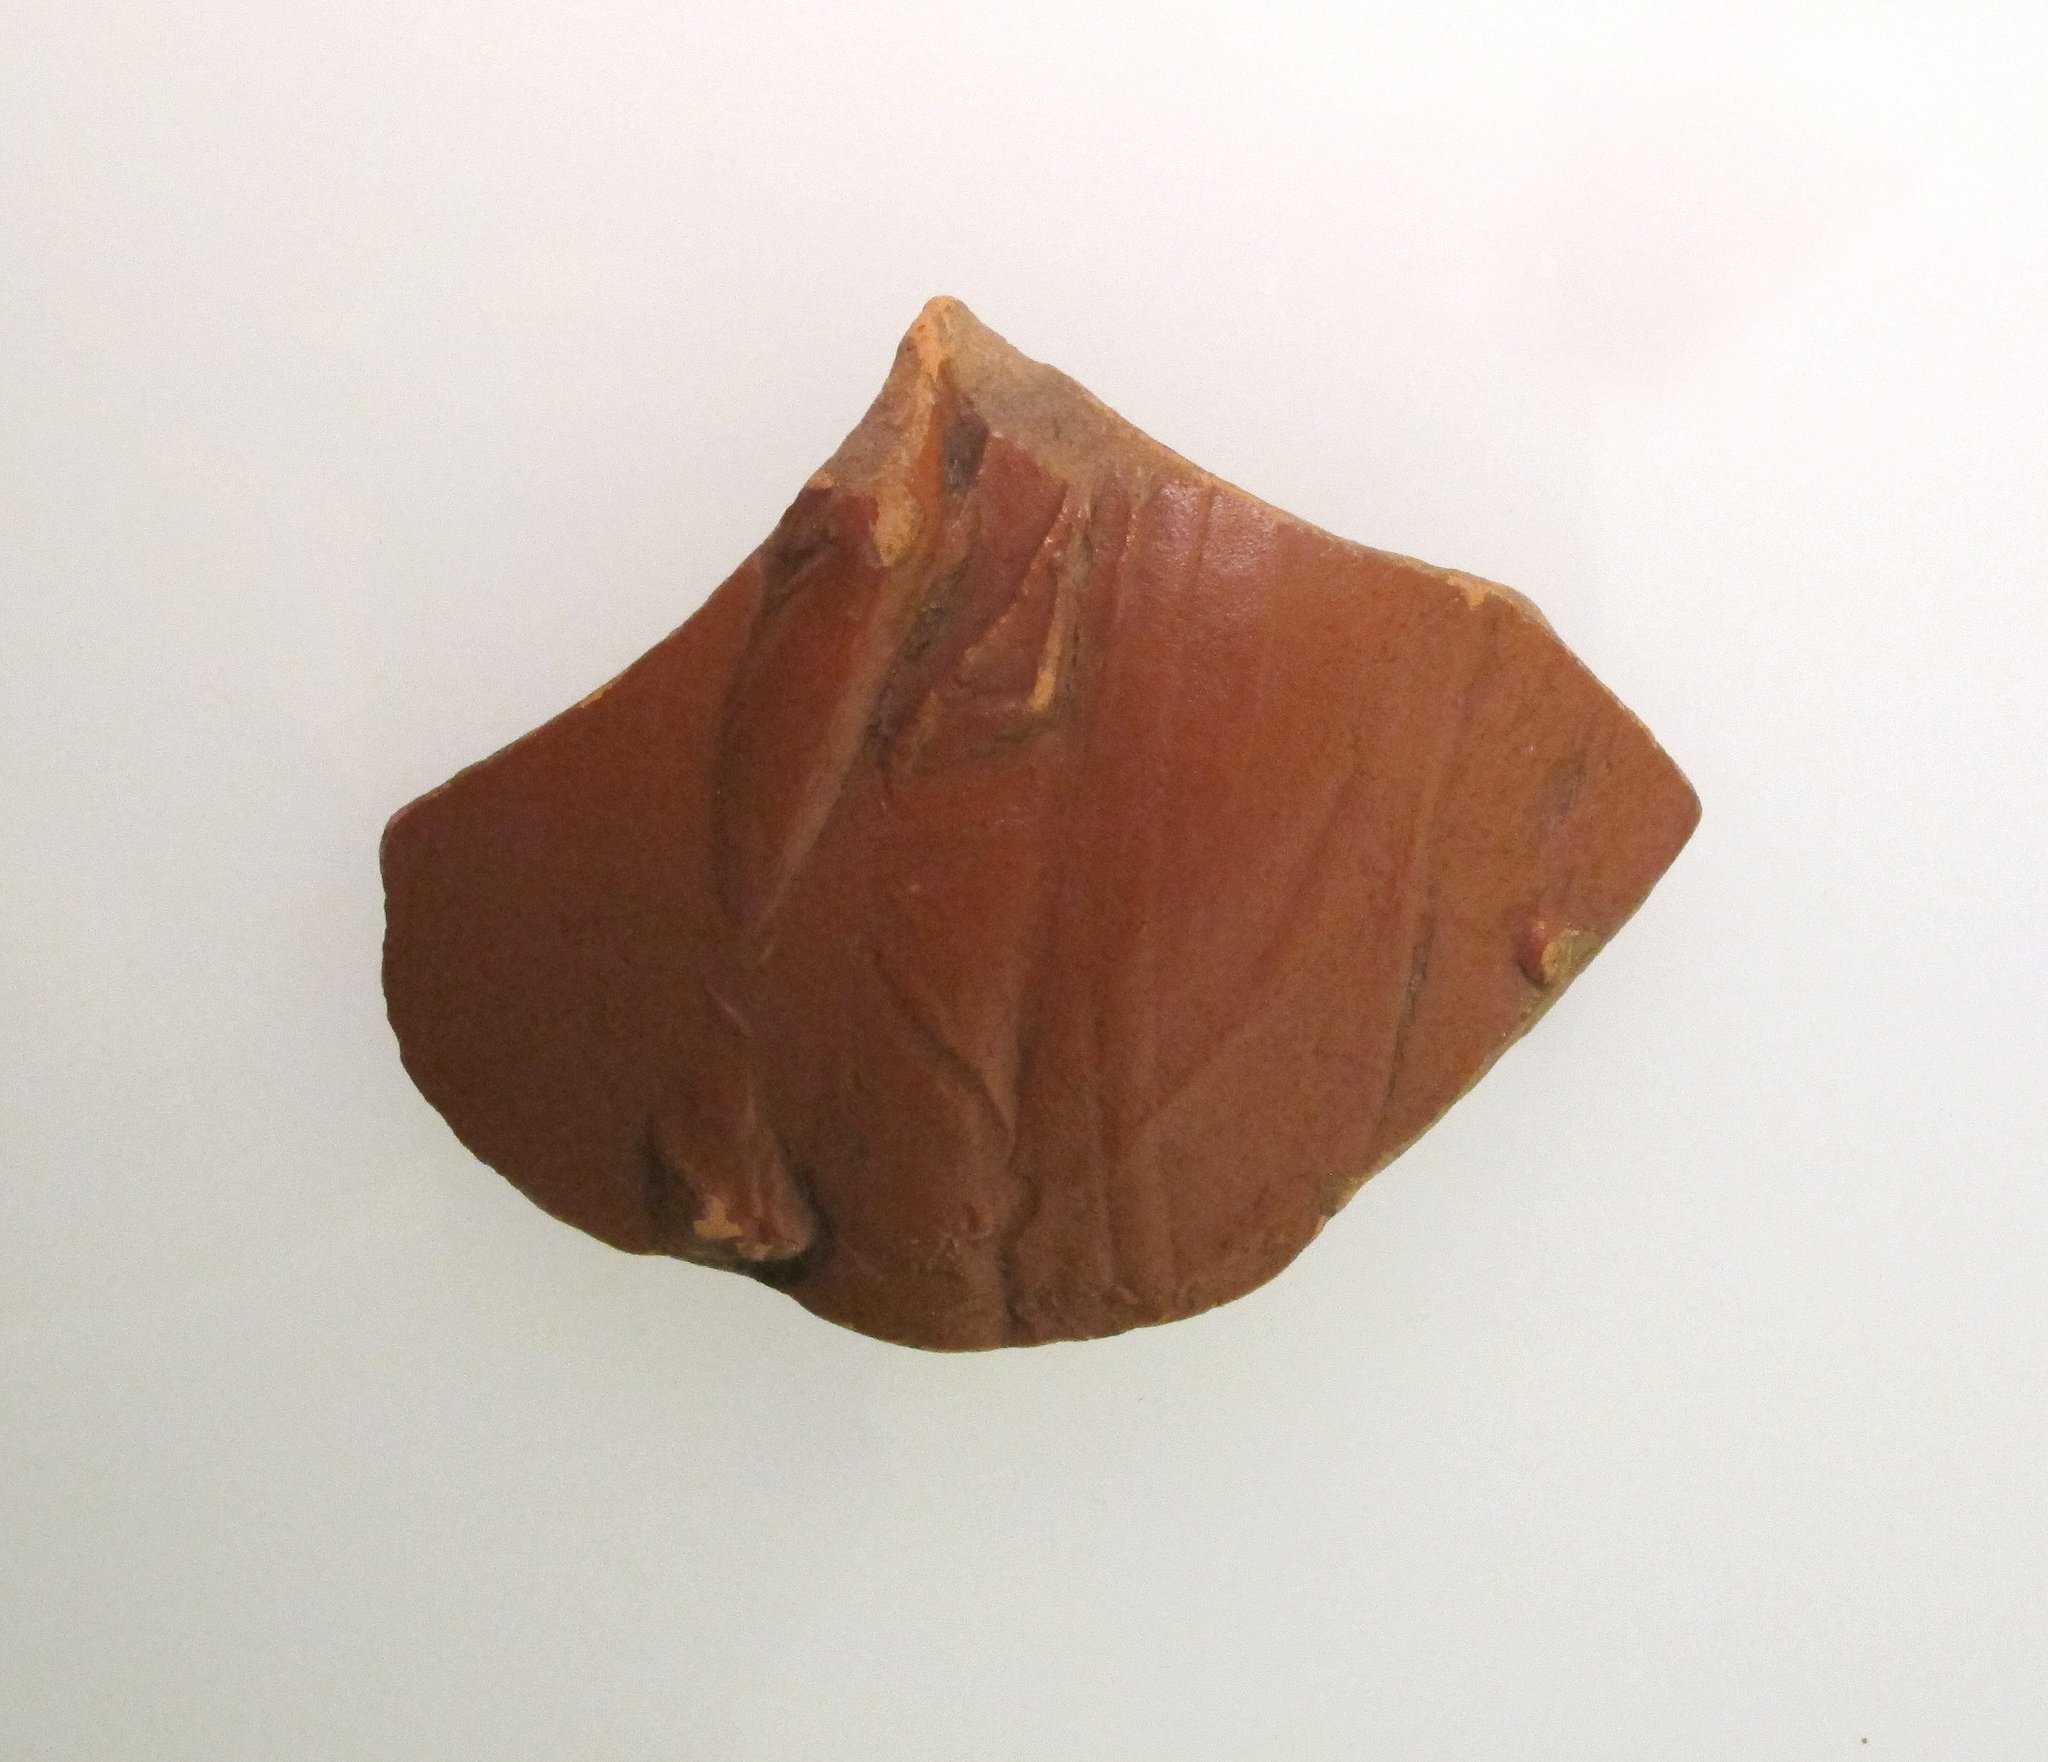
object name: vase fragment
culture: roman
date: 100 BCE-100 CE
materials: terracotta